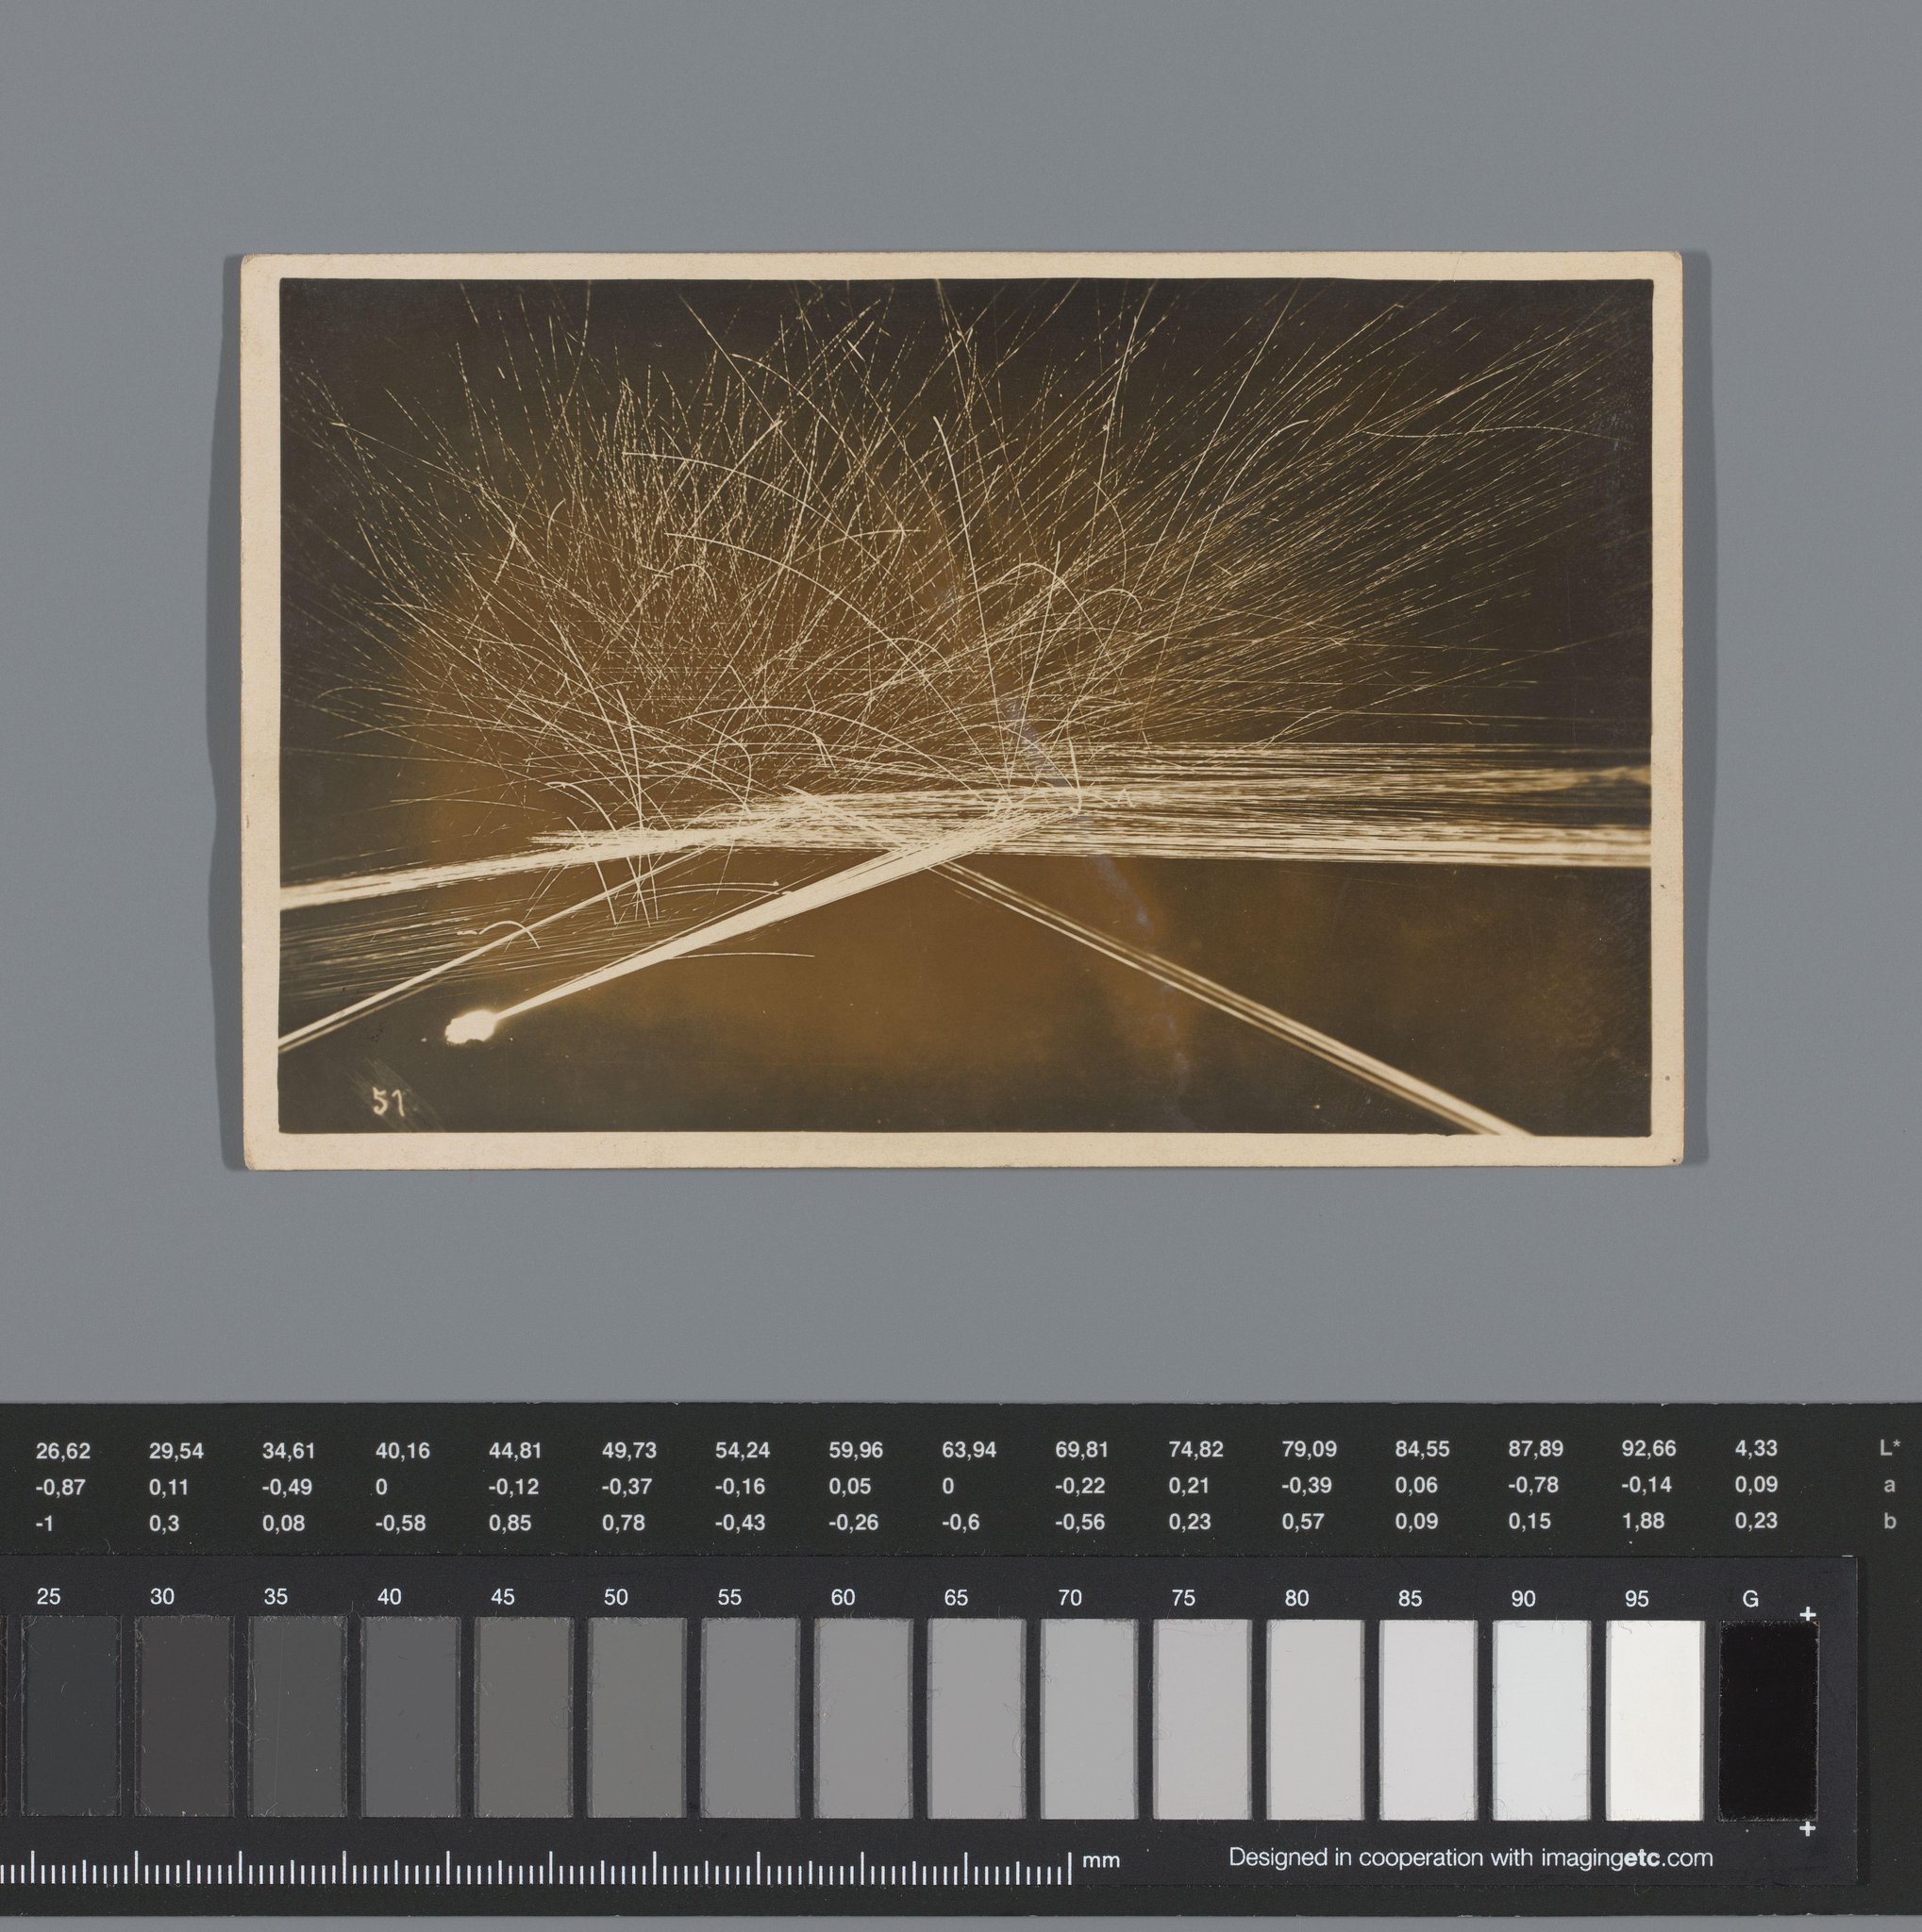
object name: photograph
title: Spervuur met mitrailleur(s) bij avond of nacht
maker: e. widmer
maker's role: fotograaf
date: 1930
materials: paper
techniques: gelatin silver print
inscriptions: number: ‘51’, name: ‘PHOTO WIDMER, WALLENSTADT’, inscription: ‘Tir de barrage / mitrailleuse / F.M. - / F.J.’